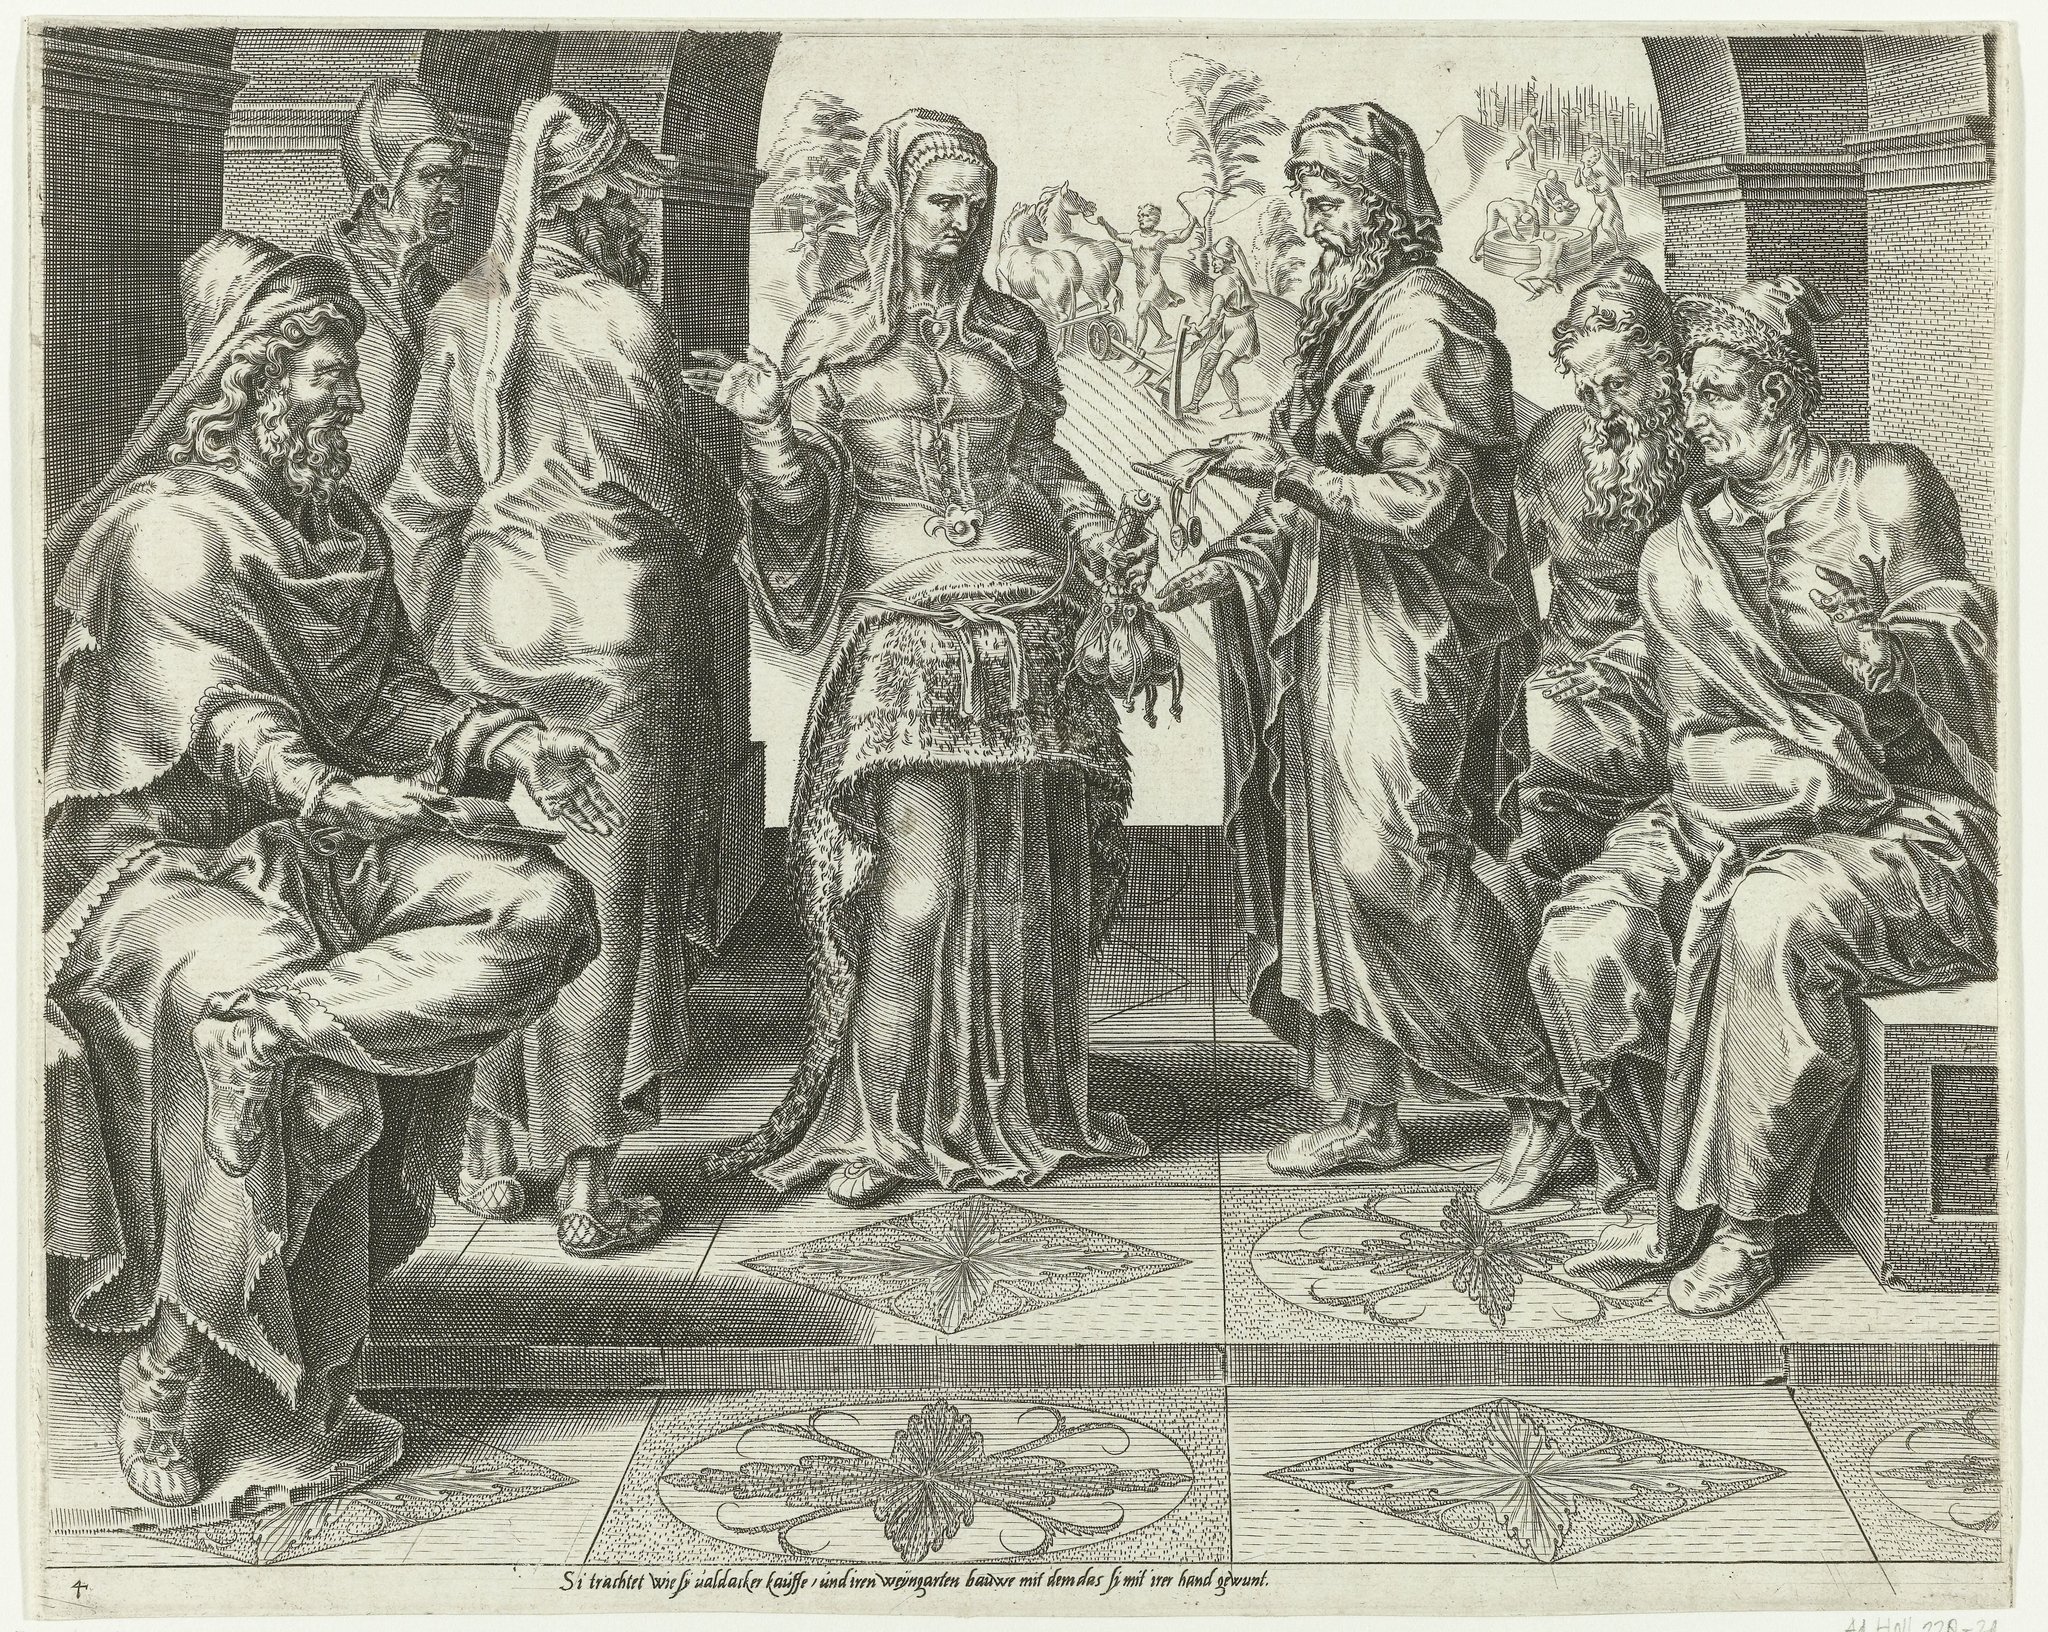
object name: print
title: Lof op de Deugdzame Huisvrouw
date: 1555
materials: paper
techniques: engraving, etching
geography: haarlem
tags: the book of proverbs (with book chapter:verse), cultivated land, ideal wife, buying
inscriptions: collector's mark: Lugt 2228, collector's mark: Lugt 2760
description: De deugdzame vrouw geeft een beurs aan een handelaar. Ze heeft de akker op de achtergrond gekocht. De prent is gebaseerd op Spreuken 31:16: 'Als zij haar zinnen op een akker zet, koopt ze hem'. De afbeelding heeft een Duits onderschrift en maakt deel uit van een zesdelige prentserie die de bezigheden van de deugdzame huisvrouw looft.